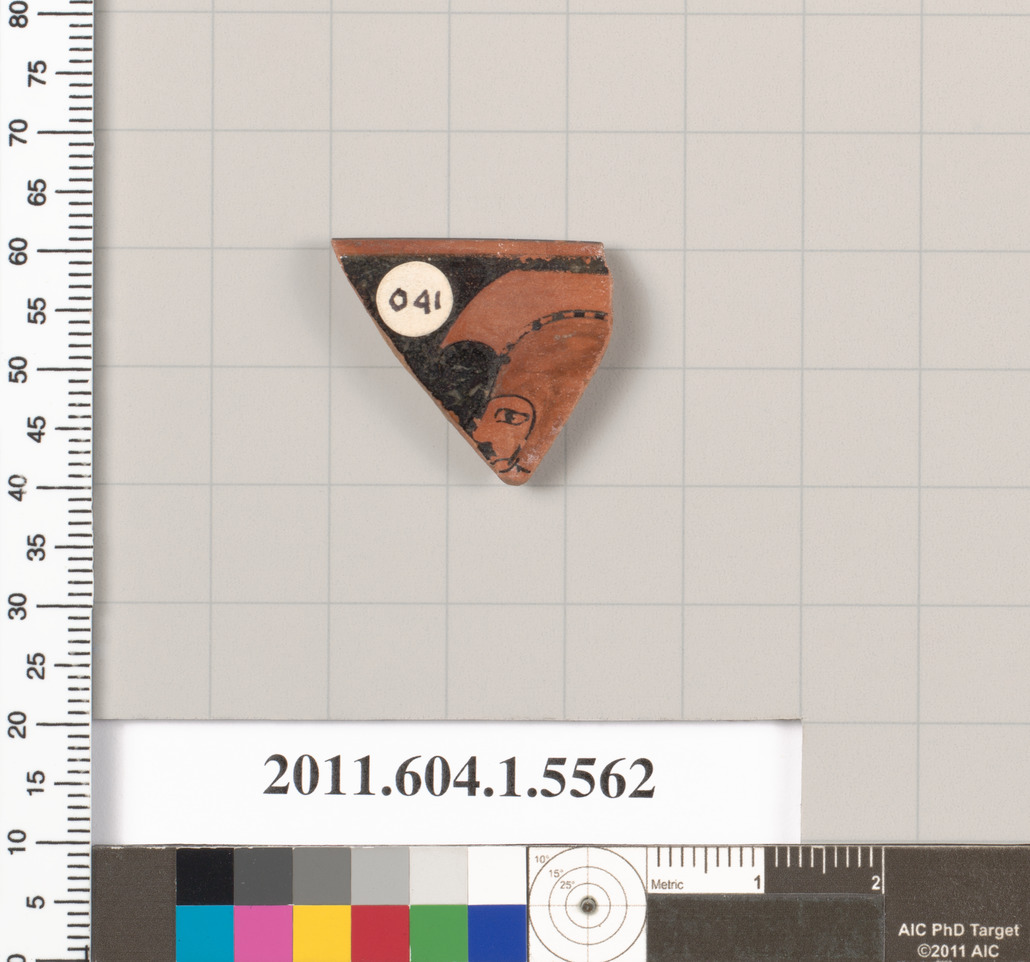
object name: kylix fragment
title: Terracotta rim fragment of a kylix (drinking cup)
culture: greek, attic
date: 520-510 BCE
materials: terracotta